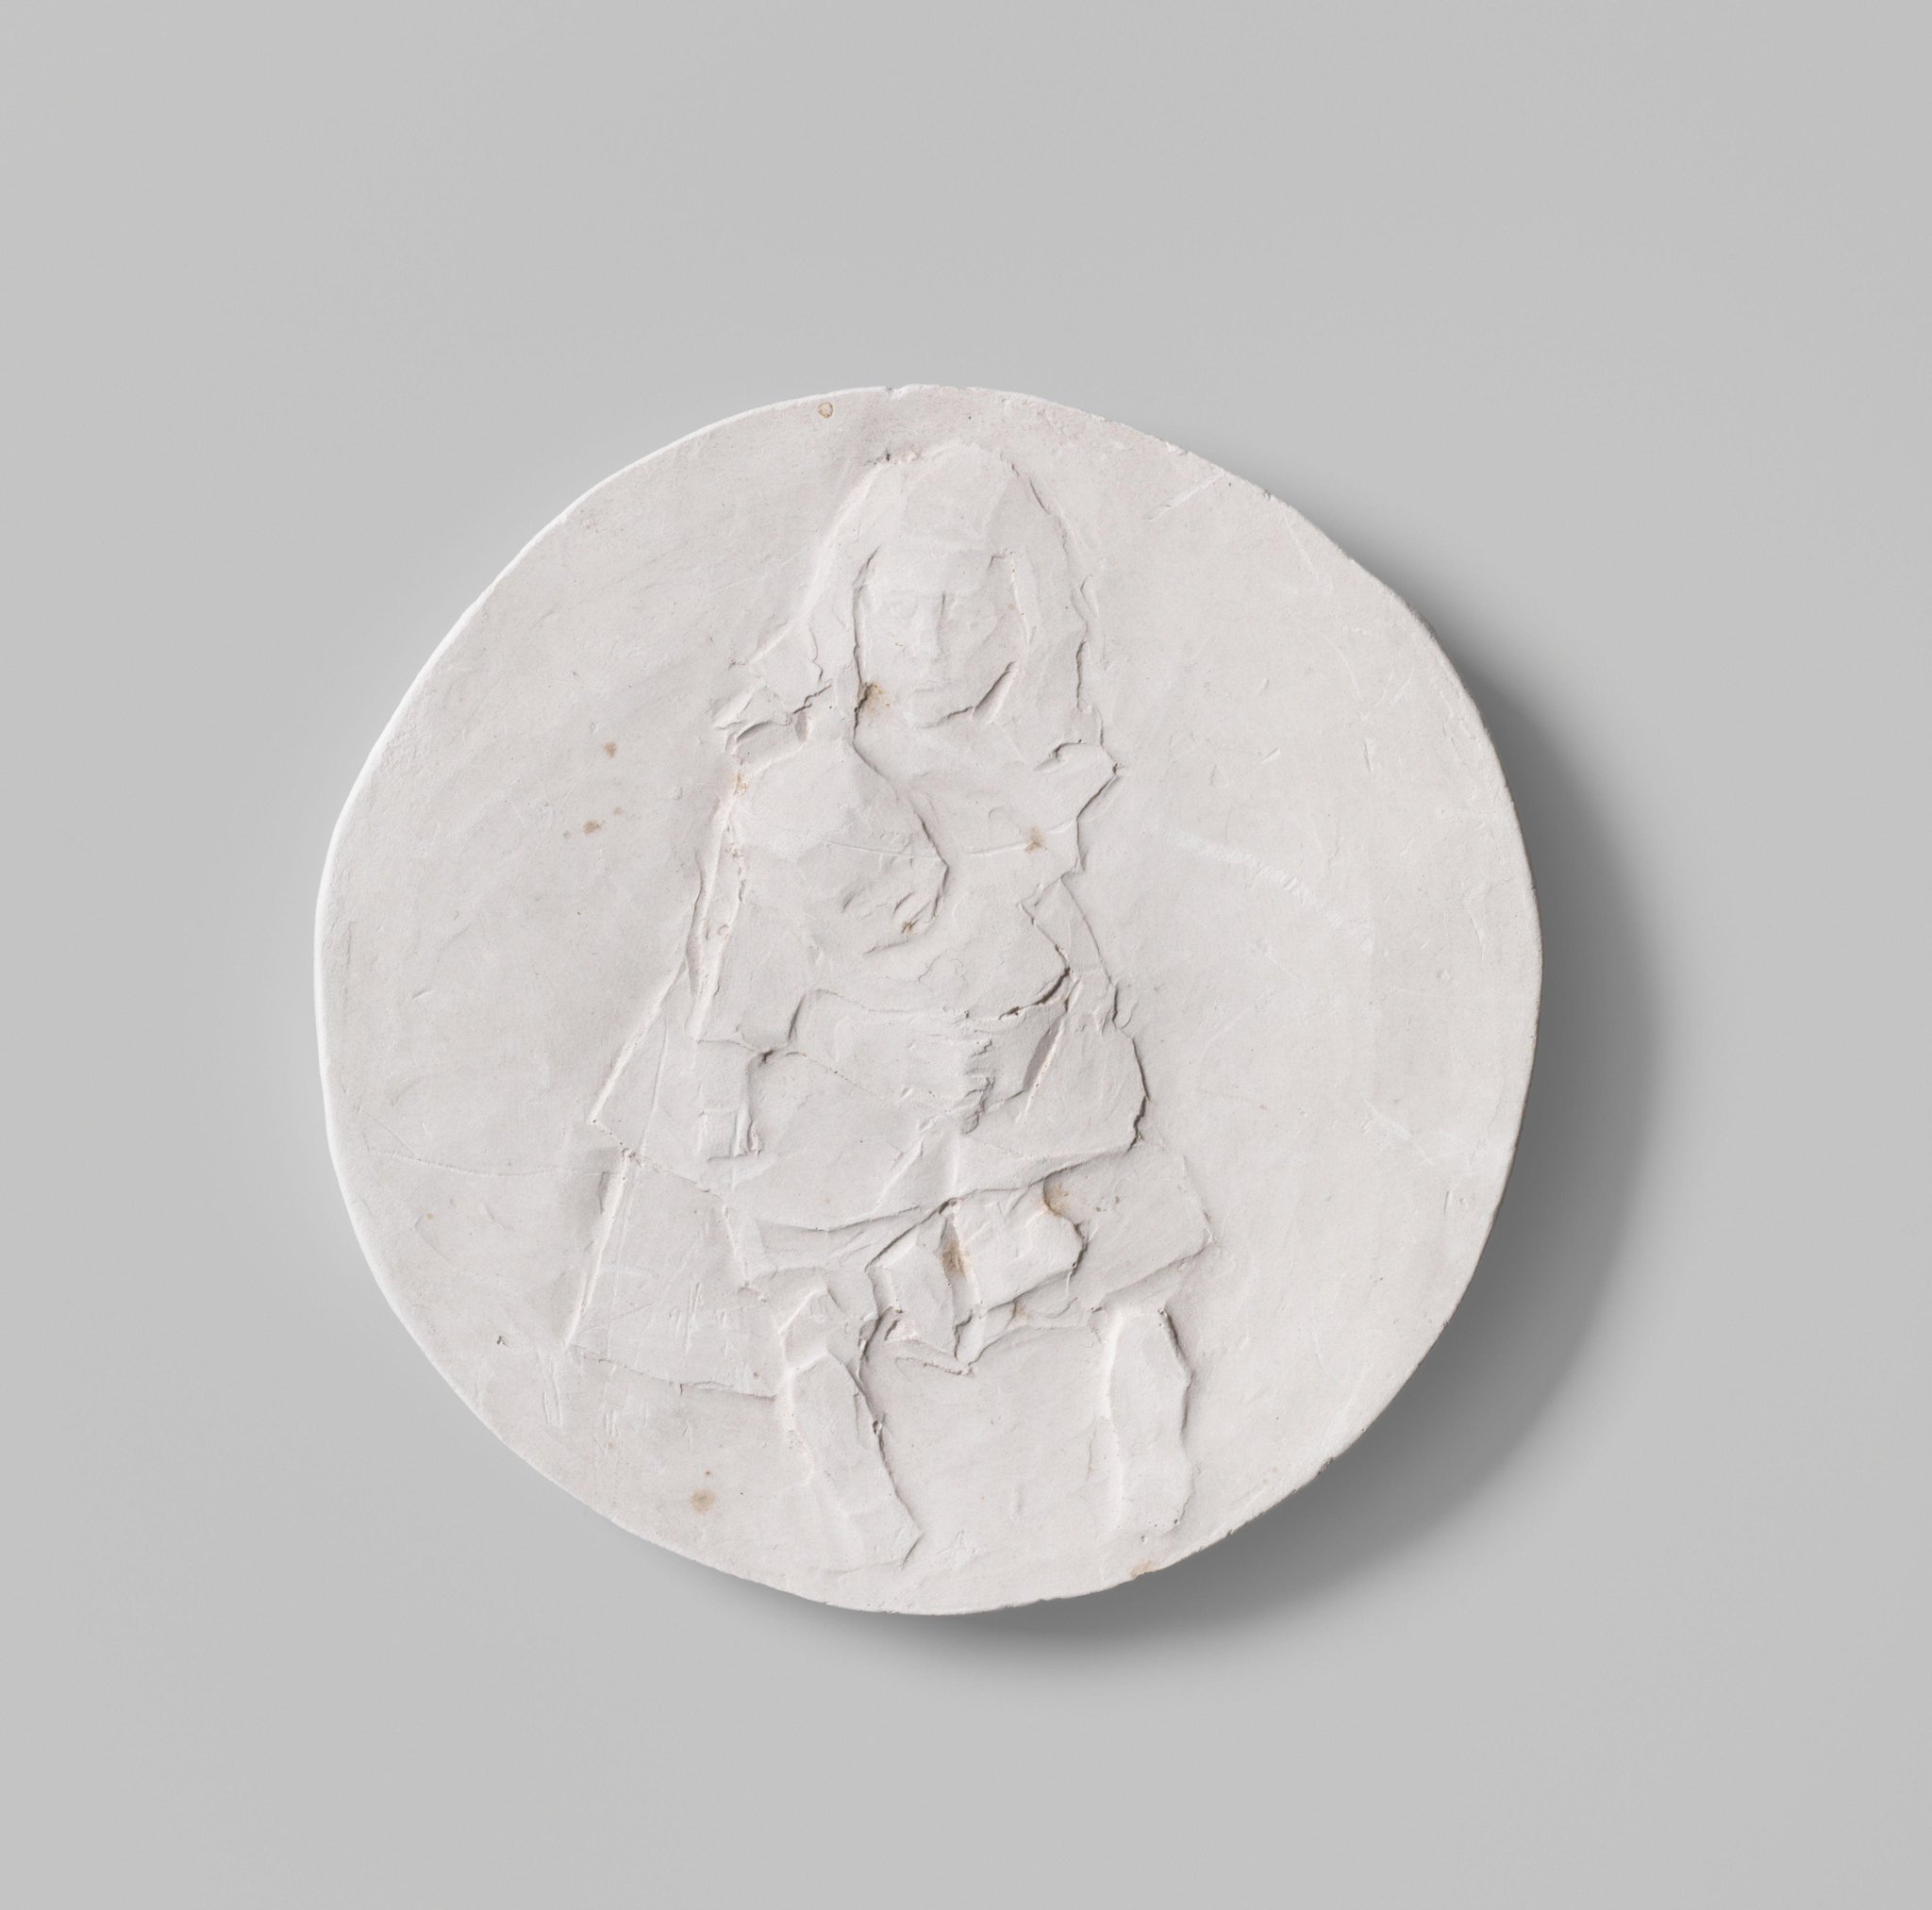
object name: medal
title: Ontwerp voor een penning (?) van gips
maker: lambertus zijl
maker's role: designer, draughtsman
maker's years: 1866-1947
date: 1876-1947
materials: gypsum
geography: netherlands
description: Ontwerp voor een penning (?) van gips met meisjesfiguur met pop